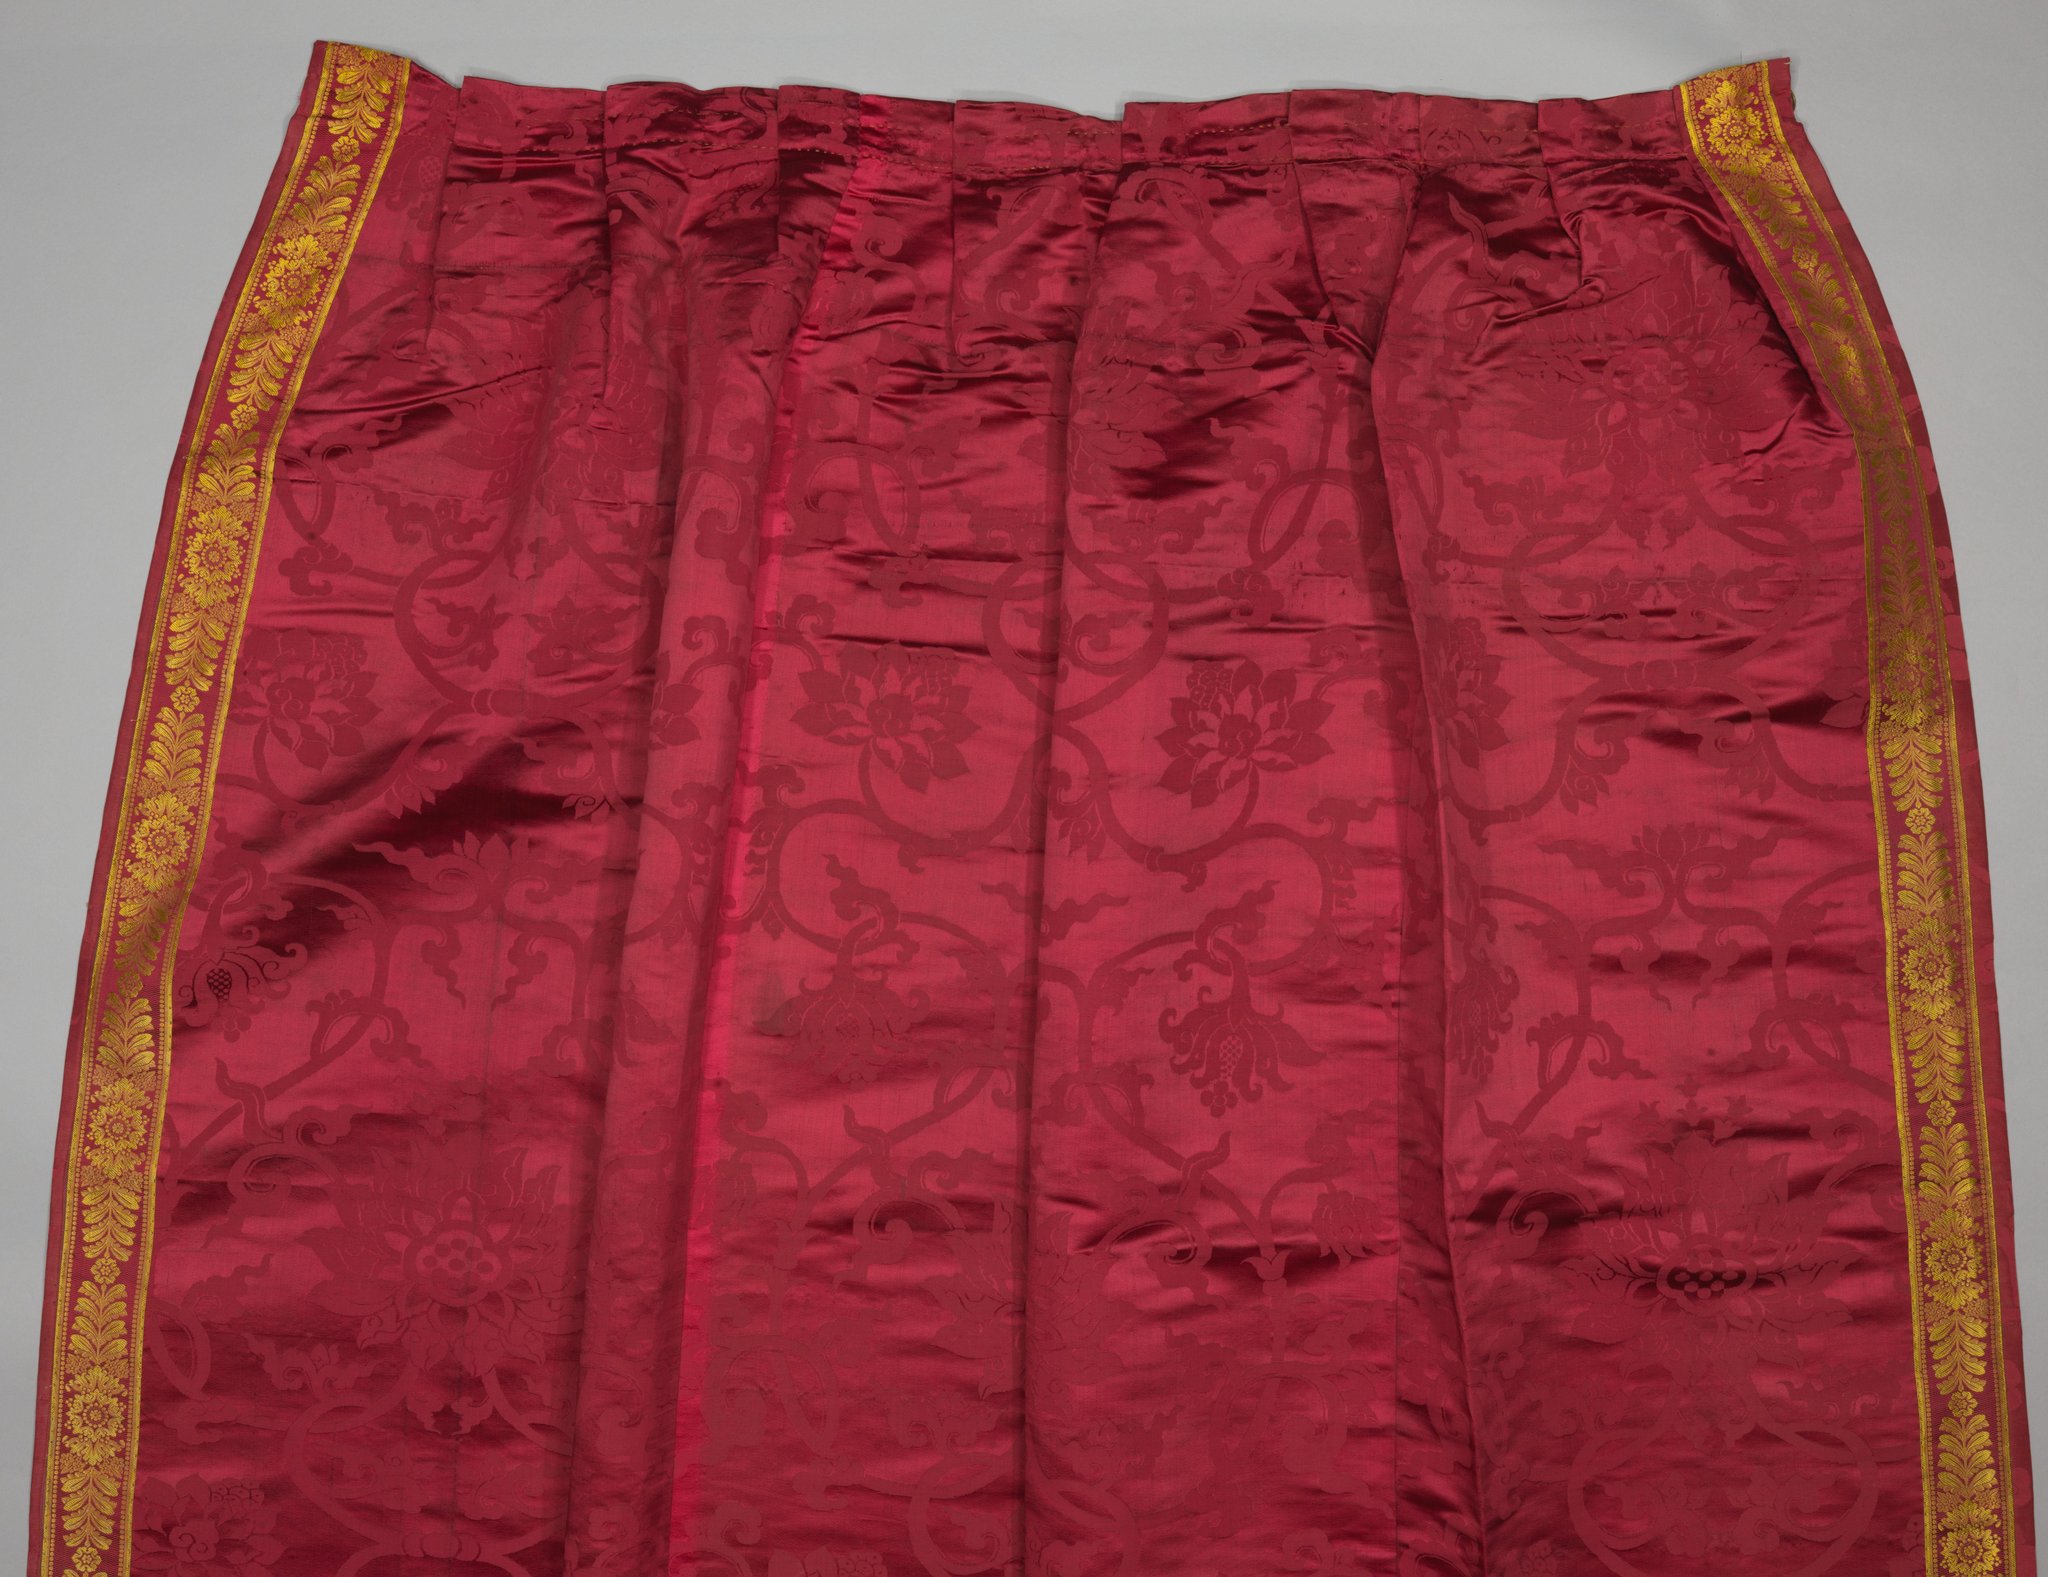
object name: curtain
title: Gordijn van rood zijdedamast met een Chinees patroon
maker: Anonymous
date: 1830-1870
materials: silk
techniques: damask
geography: china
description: Gordijn van rood zijdedamast. Een Chinees patroon met krullende takken met bladeren en bloemen. Onderaan en langs de verticale buitenzomen een 7.5 cm breed sierband, rood, met een geel motief van rozetten en bladeen. Voering uitgetornd (zie d). Aan de bovenzijde achter: boordband met koperen ringen.